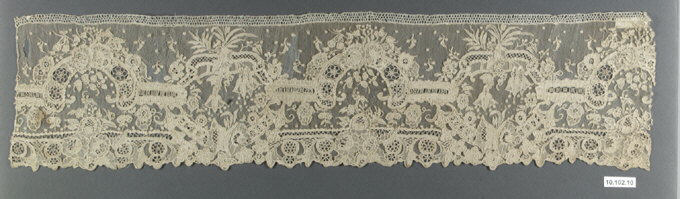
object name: fragment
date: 1801-1900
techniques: lace